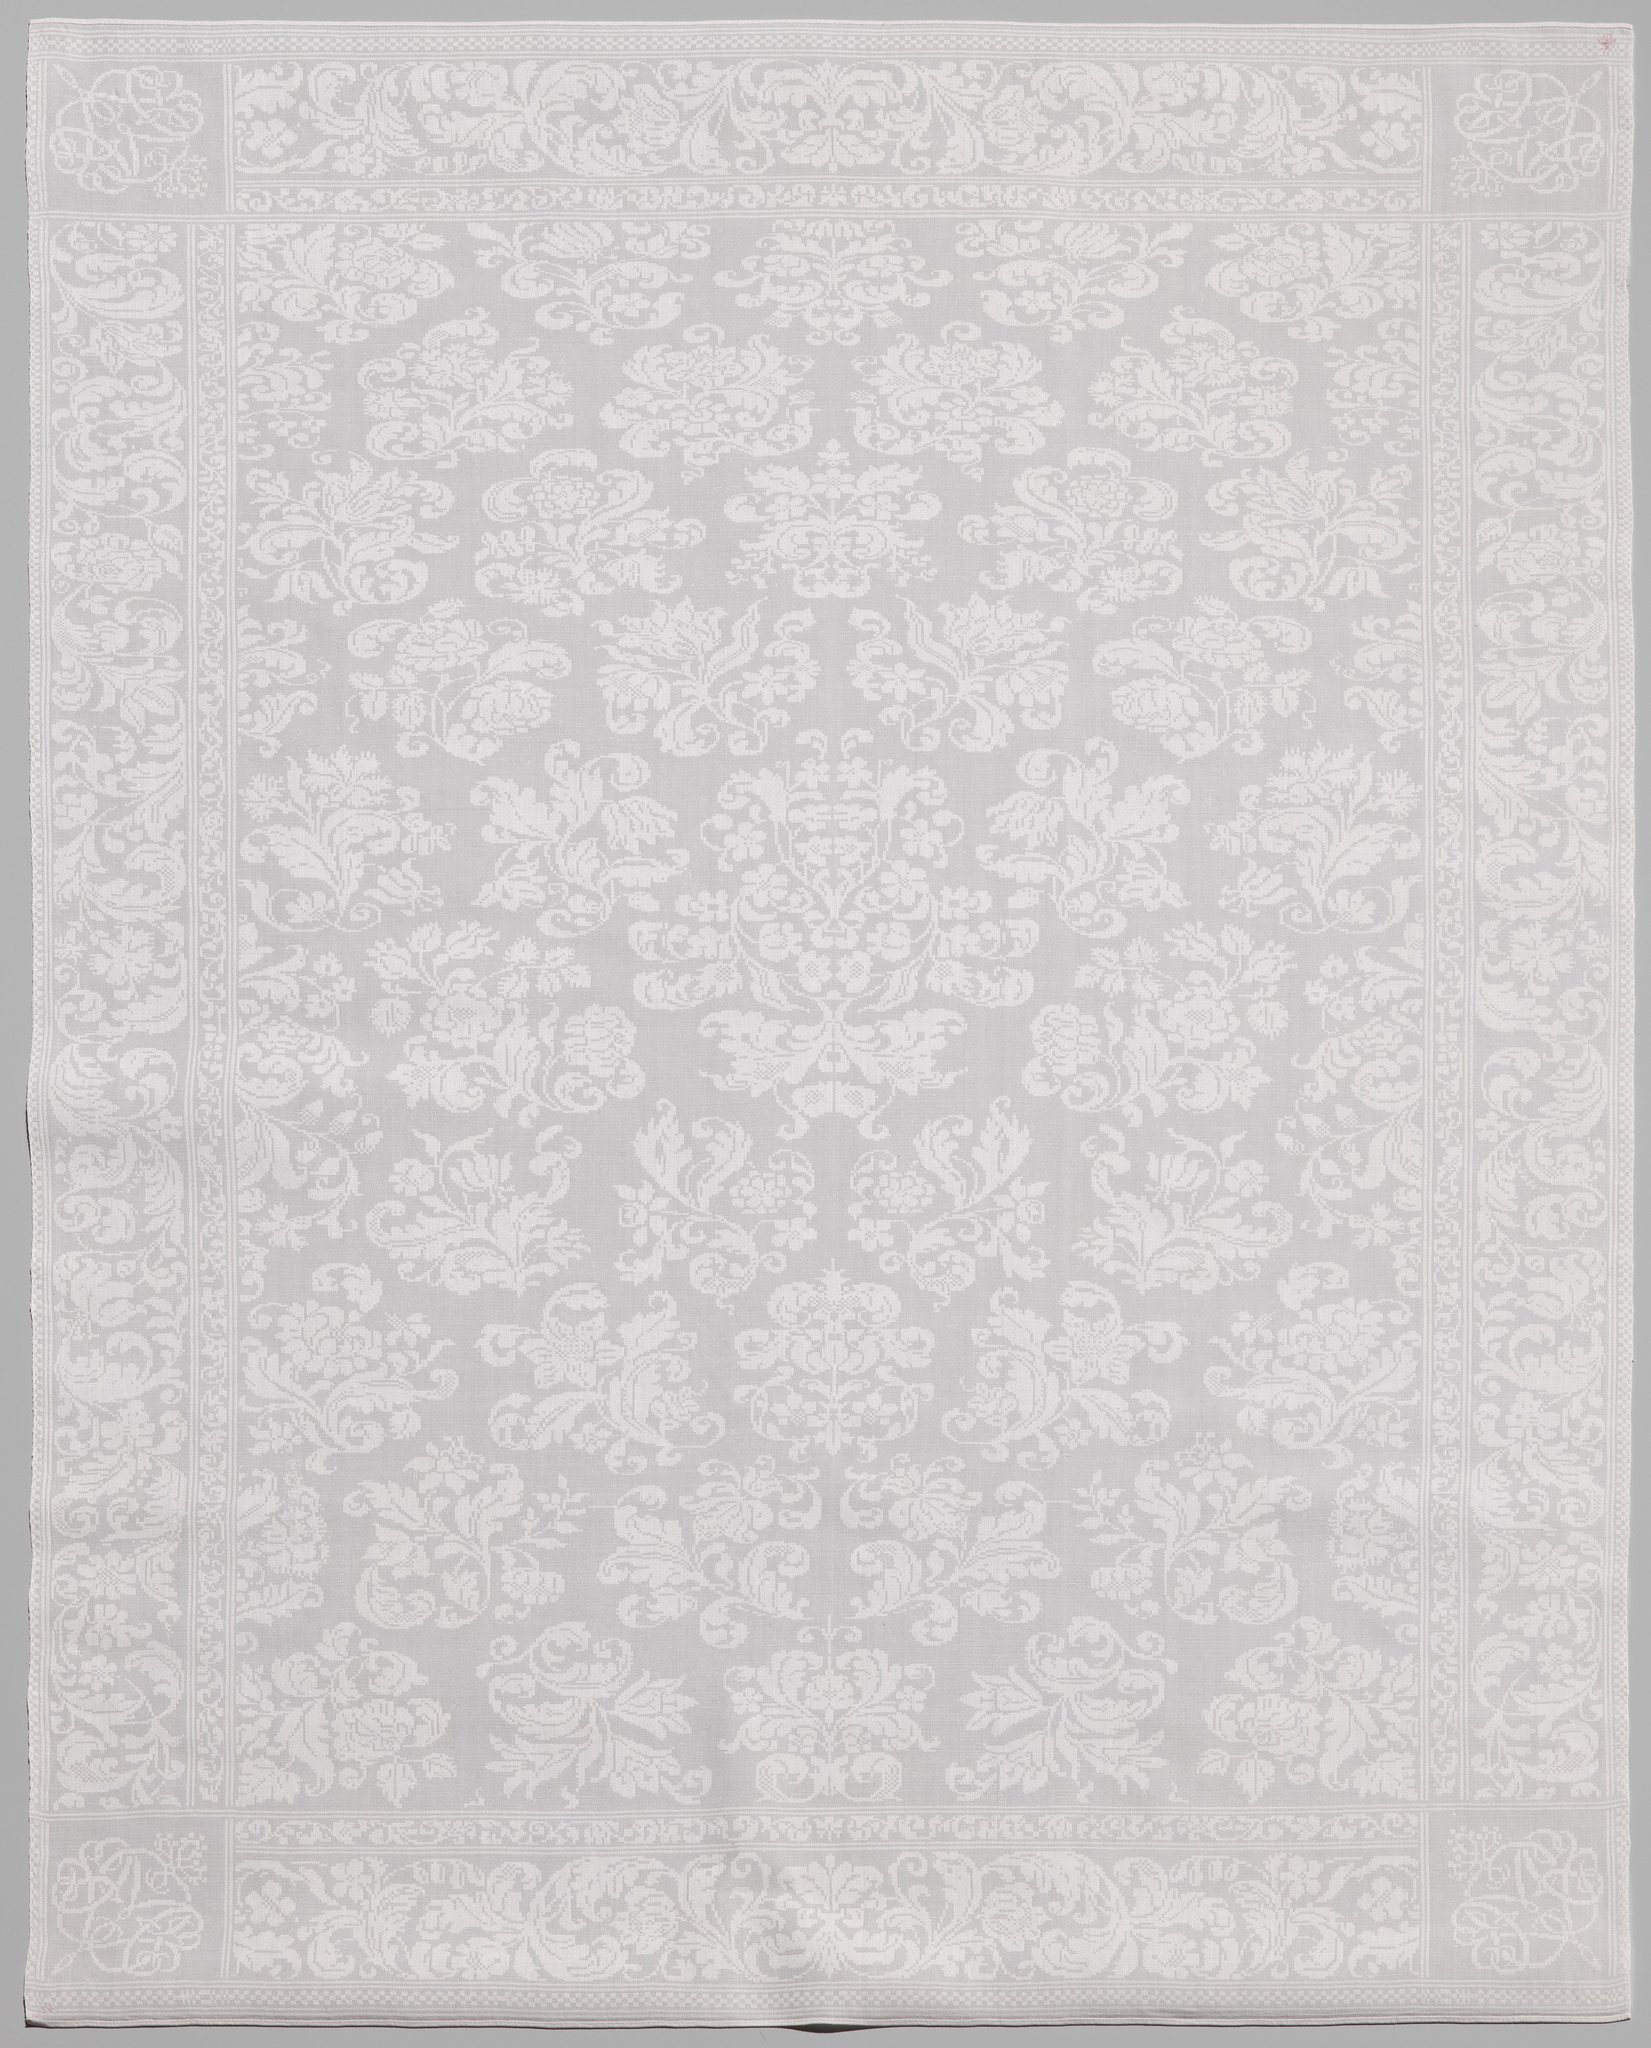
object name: napkin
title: Servet met gestrooide bloemtakken en monogram in de hoeken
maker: Anonymous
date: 1680-1690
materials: linen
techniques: damask, weave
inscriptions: : ‘24’, : ‘kroon IC’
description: Servet met gestrooide bloemtakken in het middenveld, symmetrisch patroon. Onbekend monogram (M) in de hoeken. Langs de randen een strook met eveneens gestrooide bloemtakken, gescheiden door een smalle strook met guirlandes. Dambordrand. Gemerkt: kroon IC en 24.